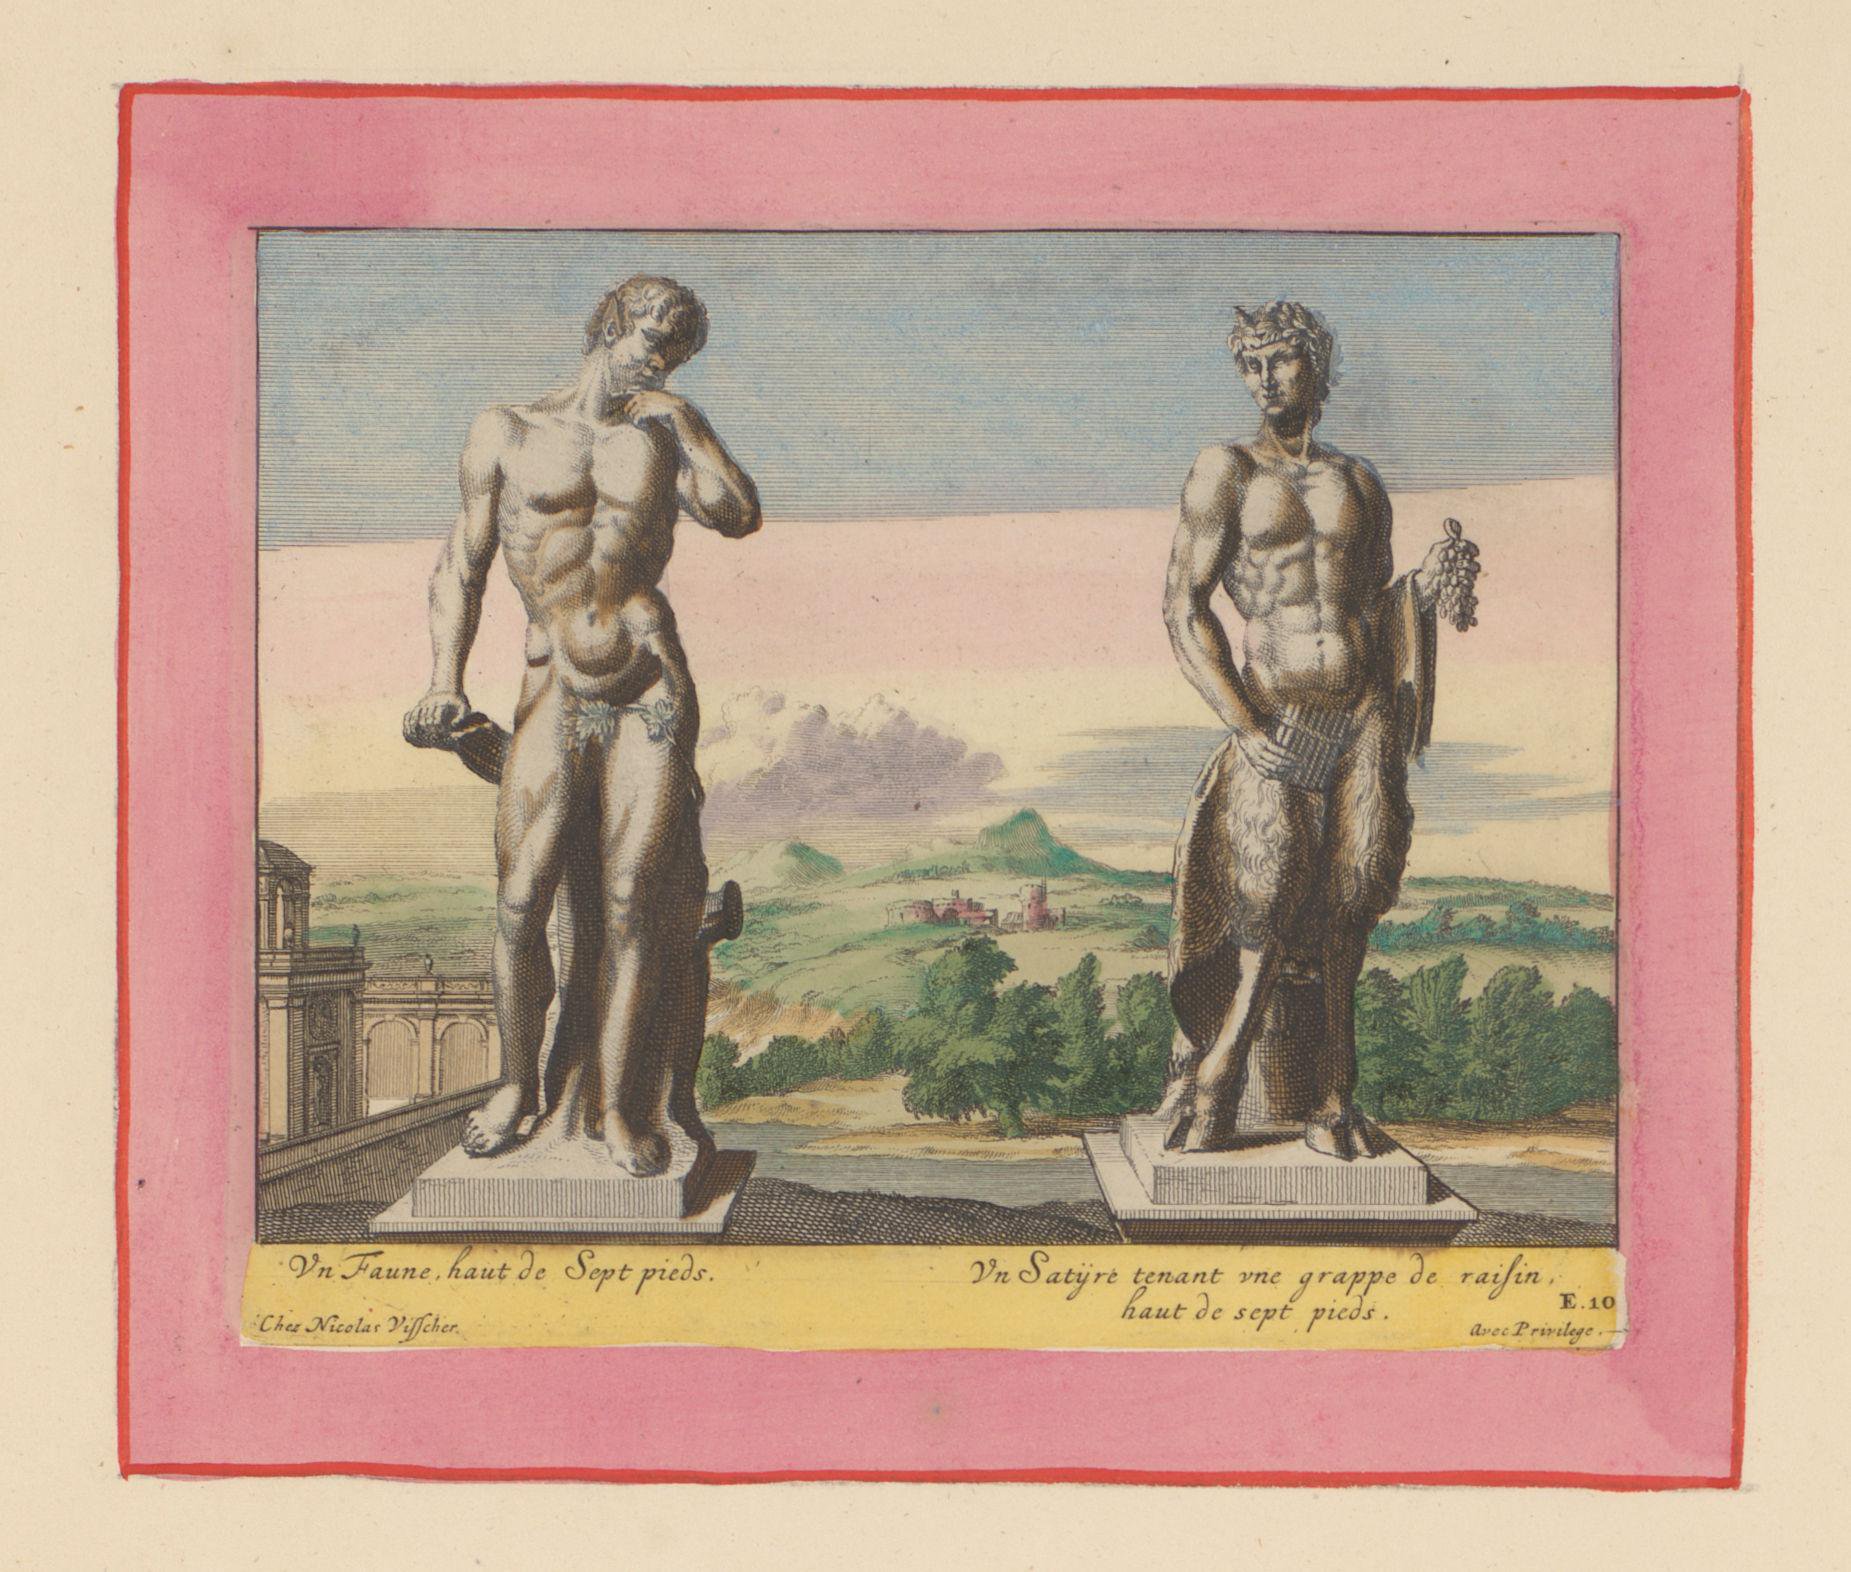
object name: print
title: Standbeelden van een faun en een sater met druiventros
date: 1686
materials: paper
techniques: etching, hand coloring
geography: amsterdam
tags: satyrs, fauns, sileni, statues, sculptures in garden, bunch of grapes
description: Standbeelden van een faun en een sater met druiventros in de tuinen van Versailles. De sater rechts vergezeld van een kleine sater. Rechtsonder het serienummer: E10. Prent maakt deel uit van een album.